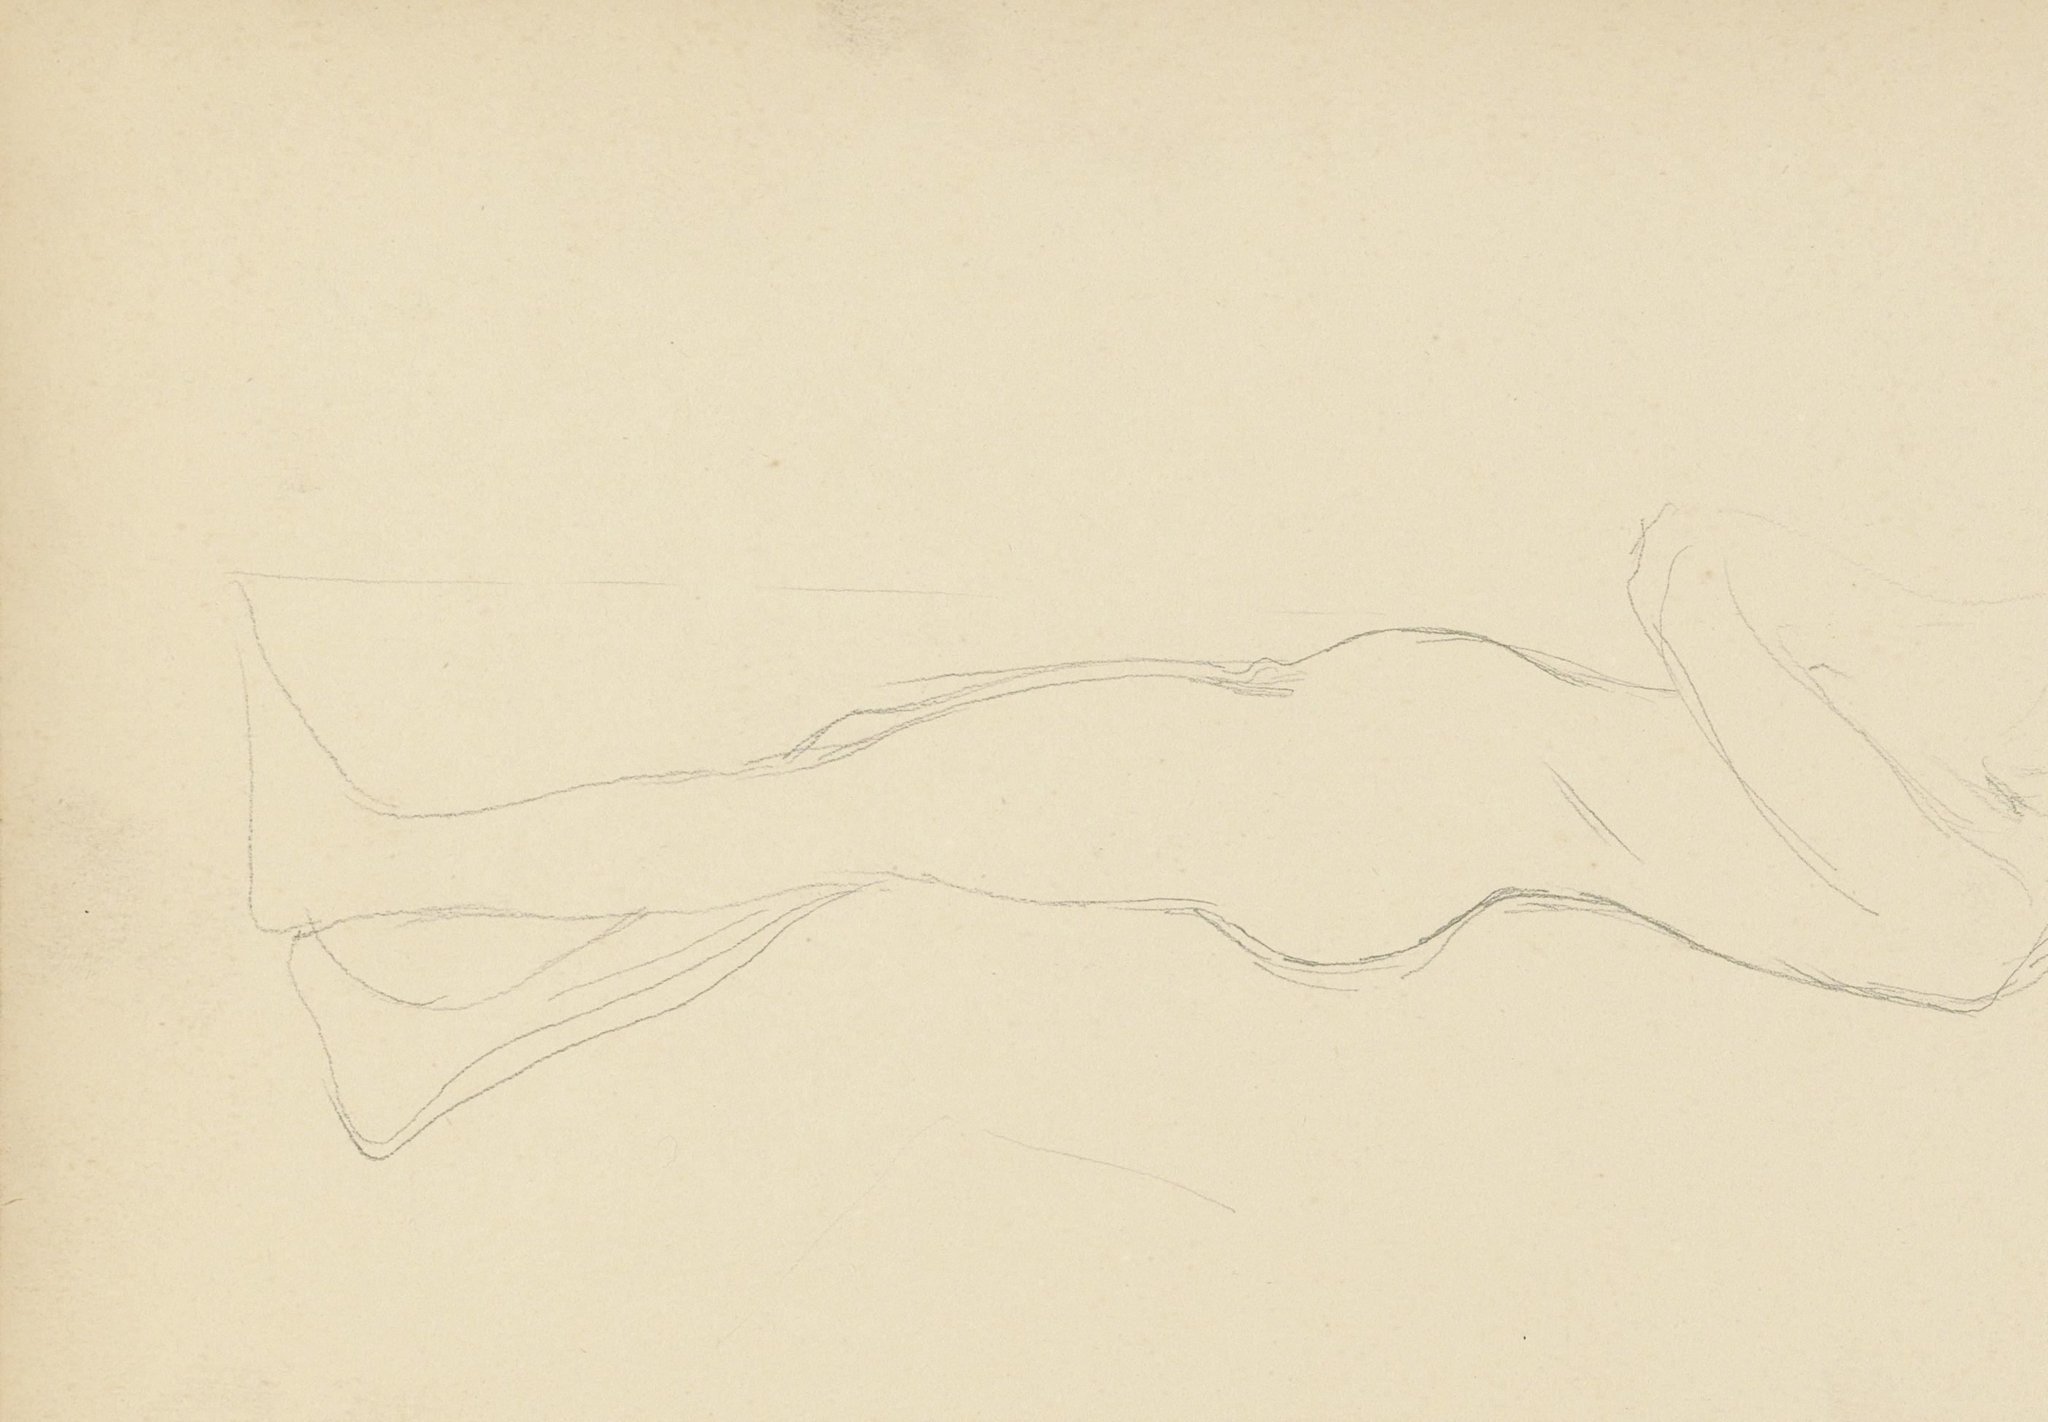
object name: sketchbook leaf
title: Staande naakte vrouw met de armen voor de borst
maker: antoon derkinderen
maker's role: draughtsman, painter, print maker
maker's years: 1859-1925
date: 1869-1925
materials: paper, pencil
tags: arms folded over the abdomen, the (nude) human figure; 'corpo humano' (ripa) - aa - female human figure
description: Blad 5 verso uit een schetsboek met 28 bladen.